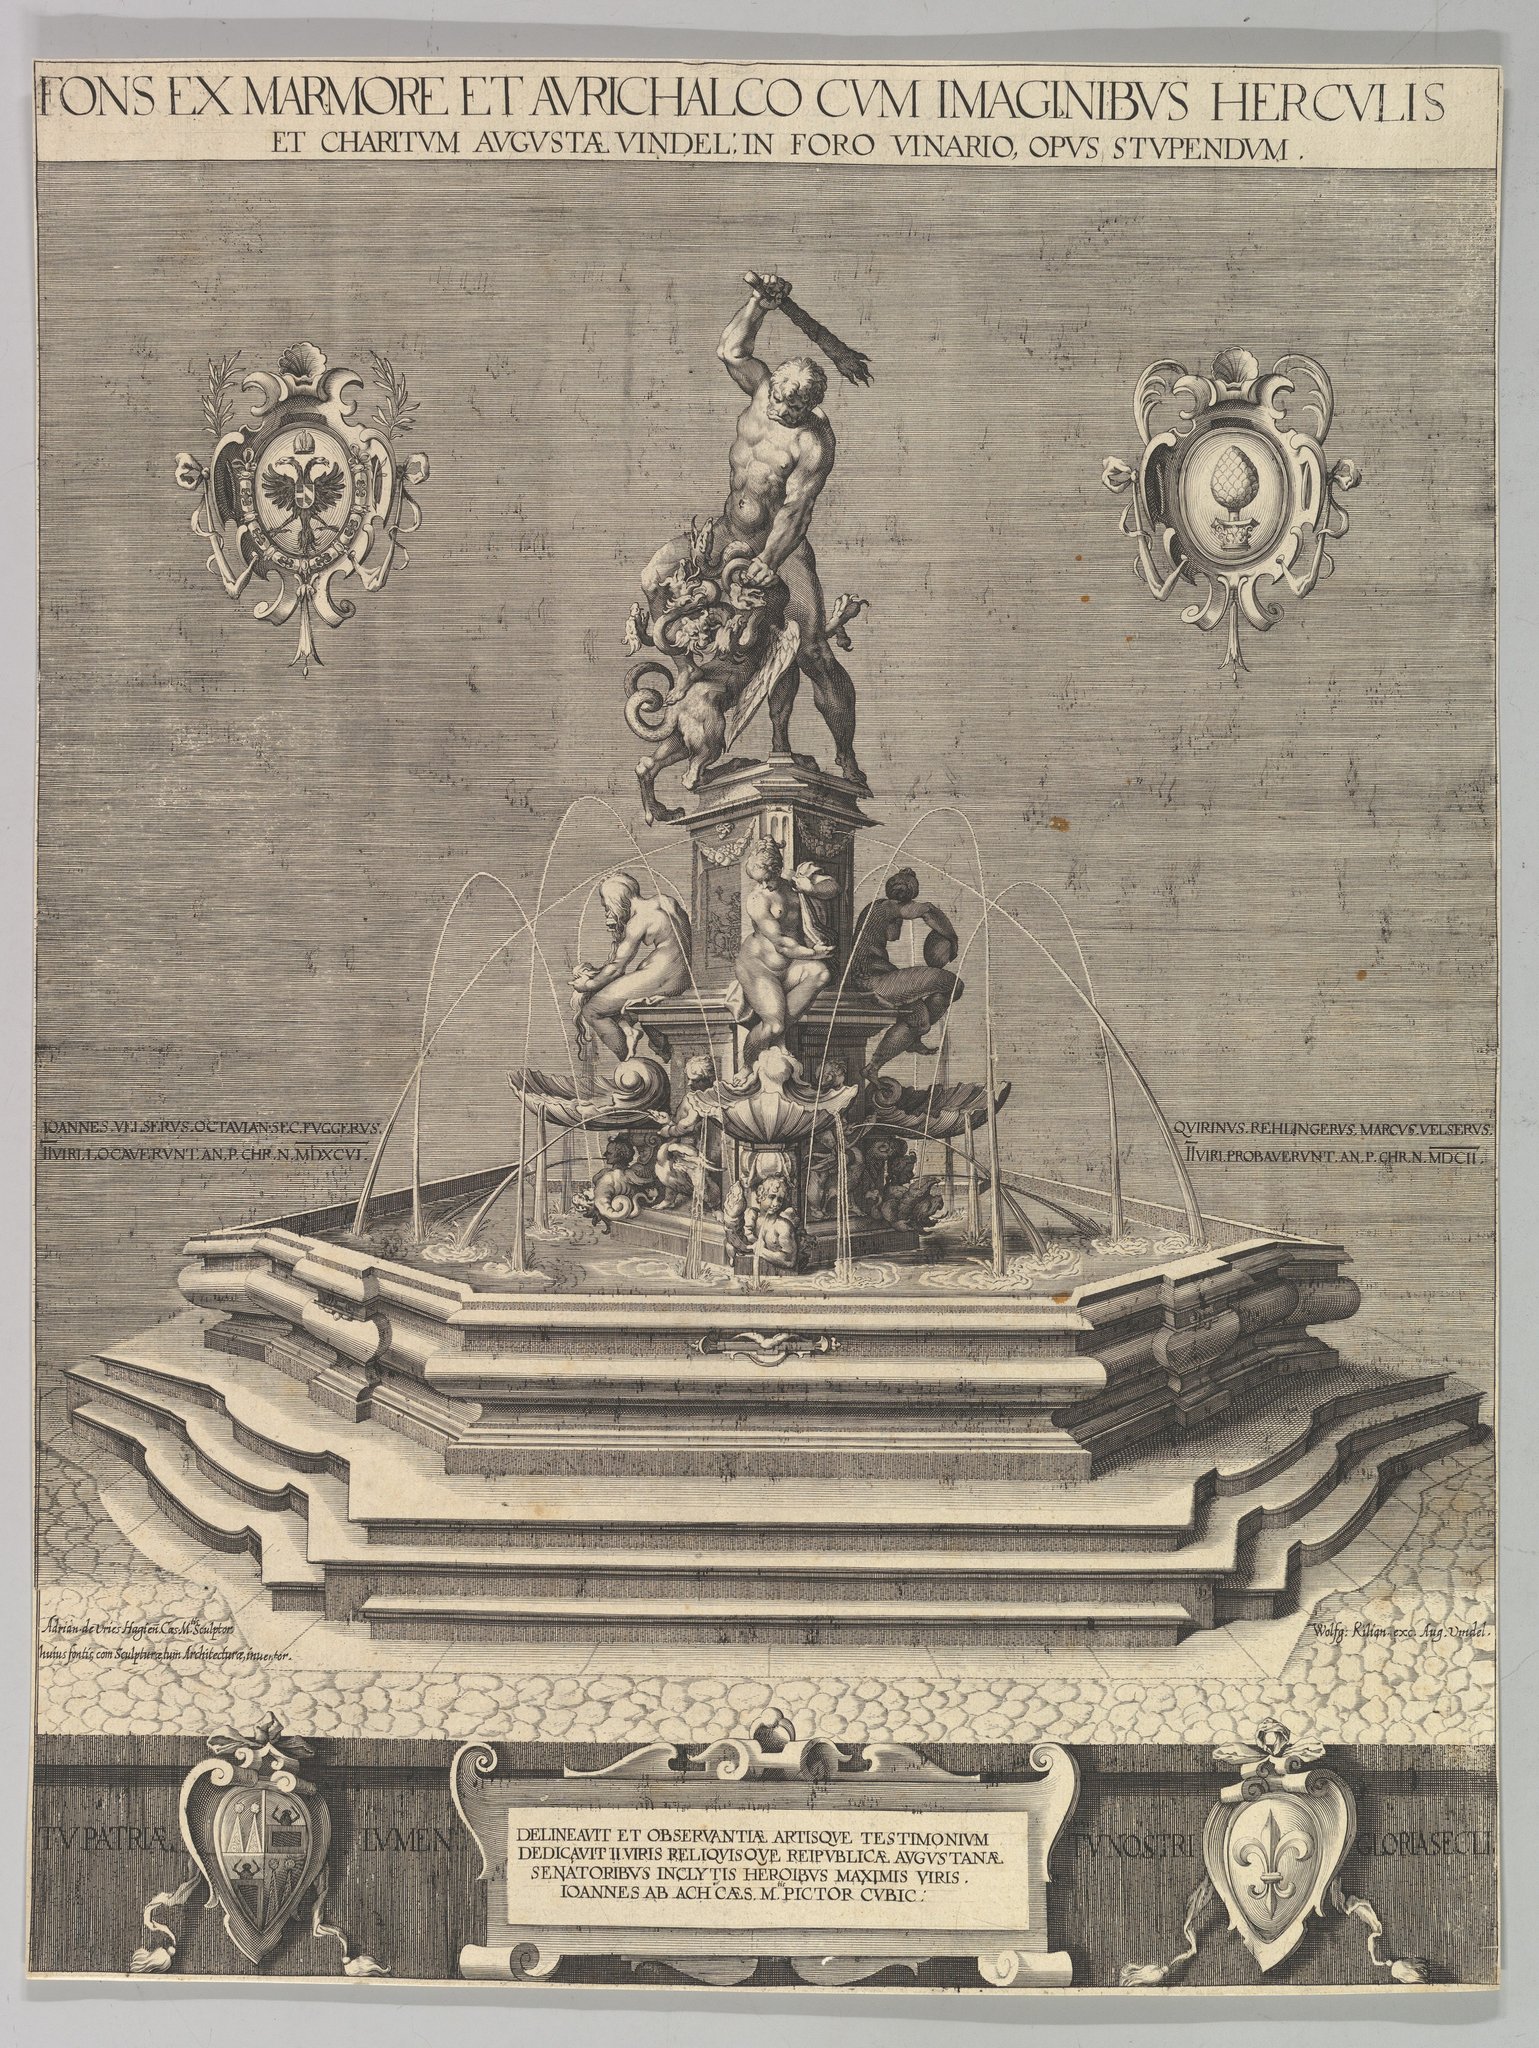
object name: print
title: The Fountain of Hercules in Augsburg, a reduced copy after Muller's engraving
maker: jan muller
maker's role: artist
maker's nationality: netherlandish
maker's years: 1571-1628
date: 1602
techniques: engraving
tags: fountains,hercules,insignia